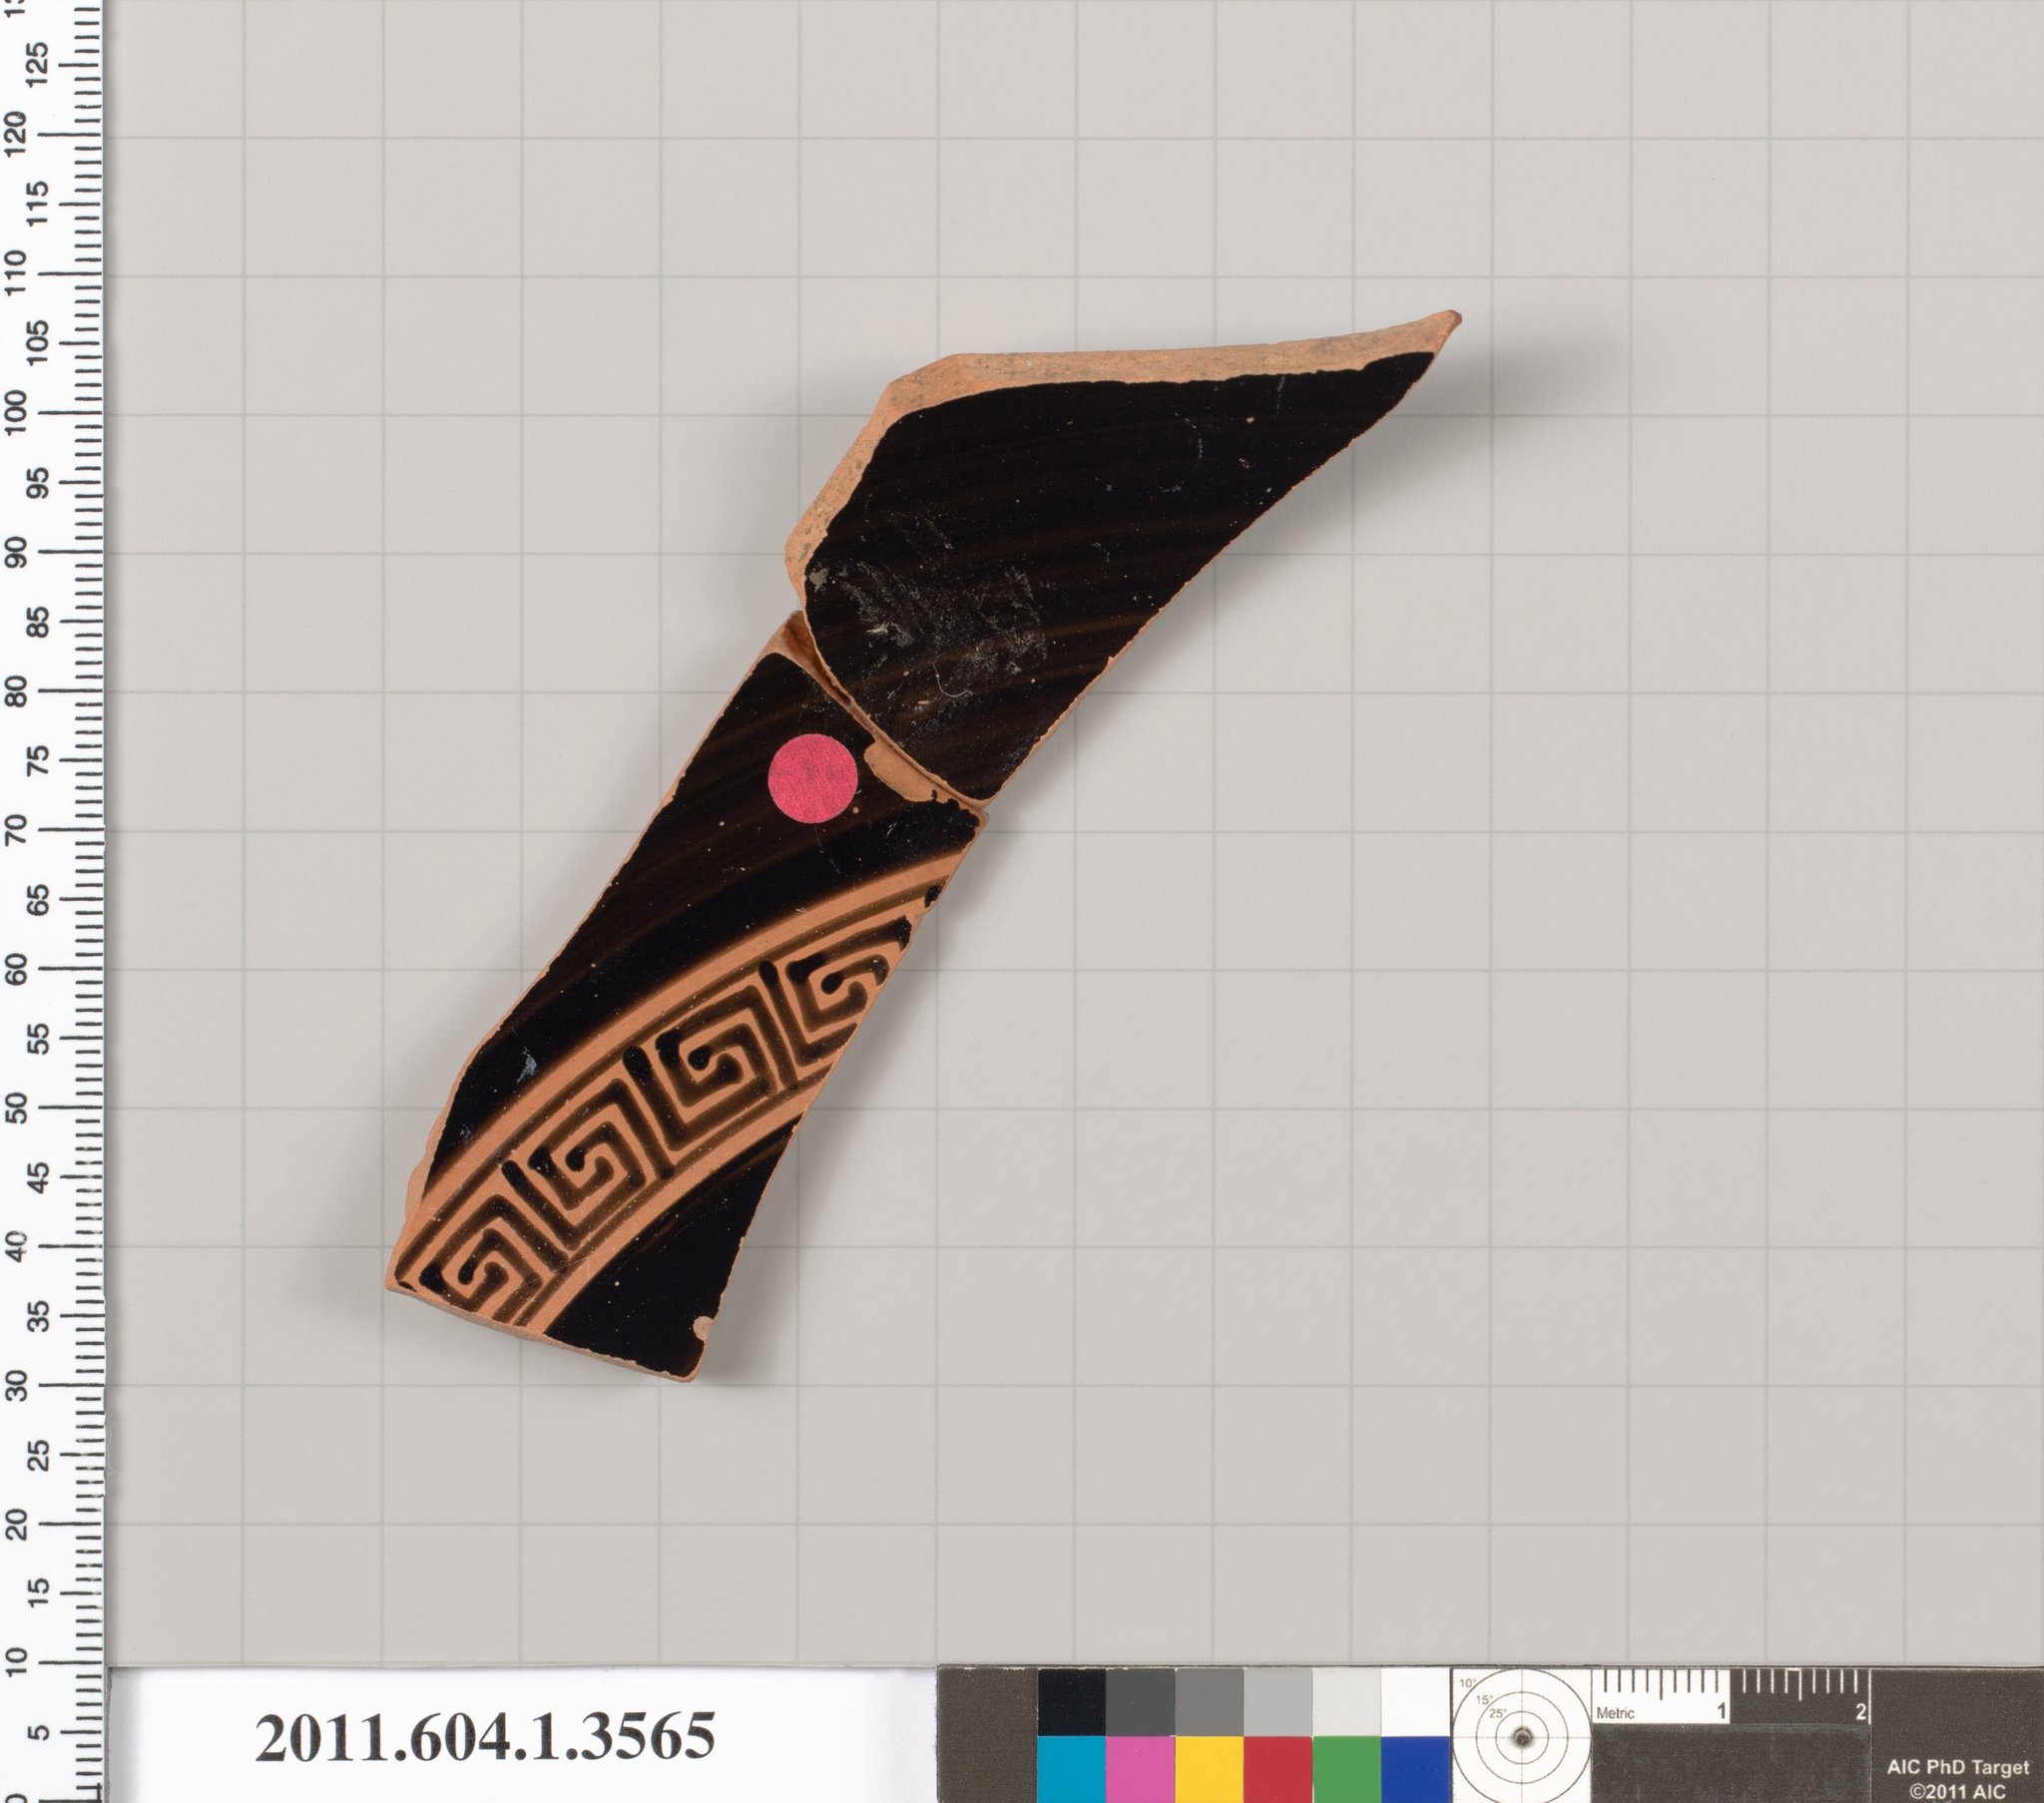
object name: kylix fragment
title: Terracotta fragment of a kylix (drinking cup)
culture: greek, attic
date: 490-480 BCE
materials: terracotta